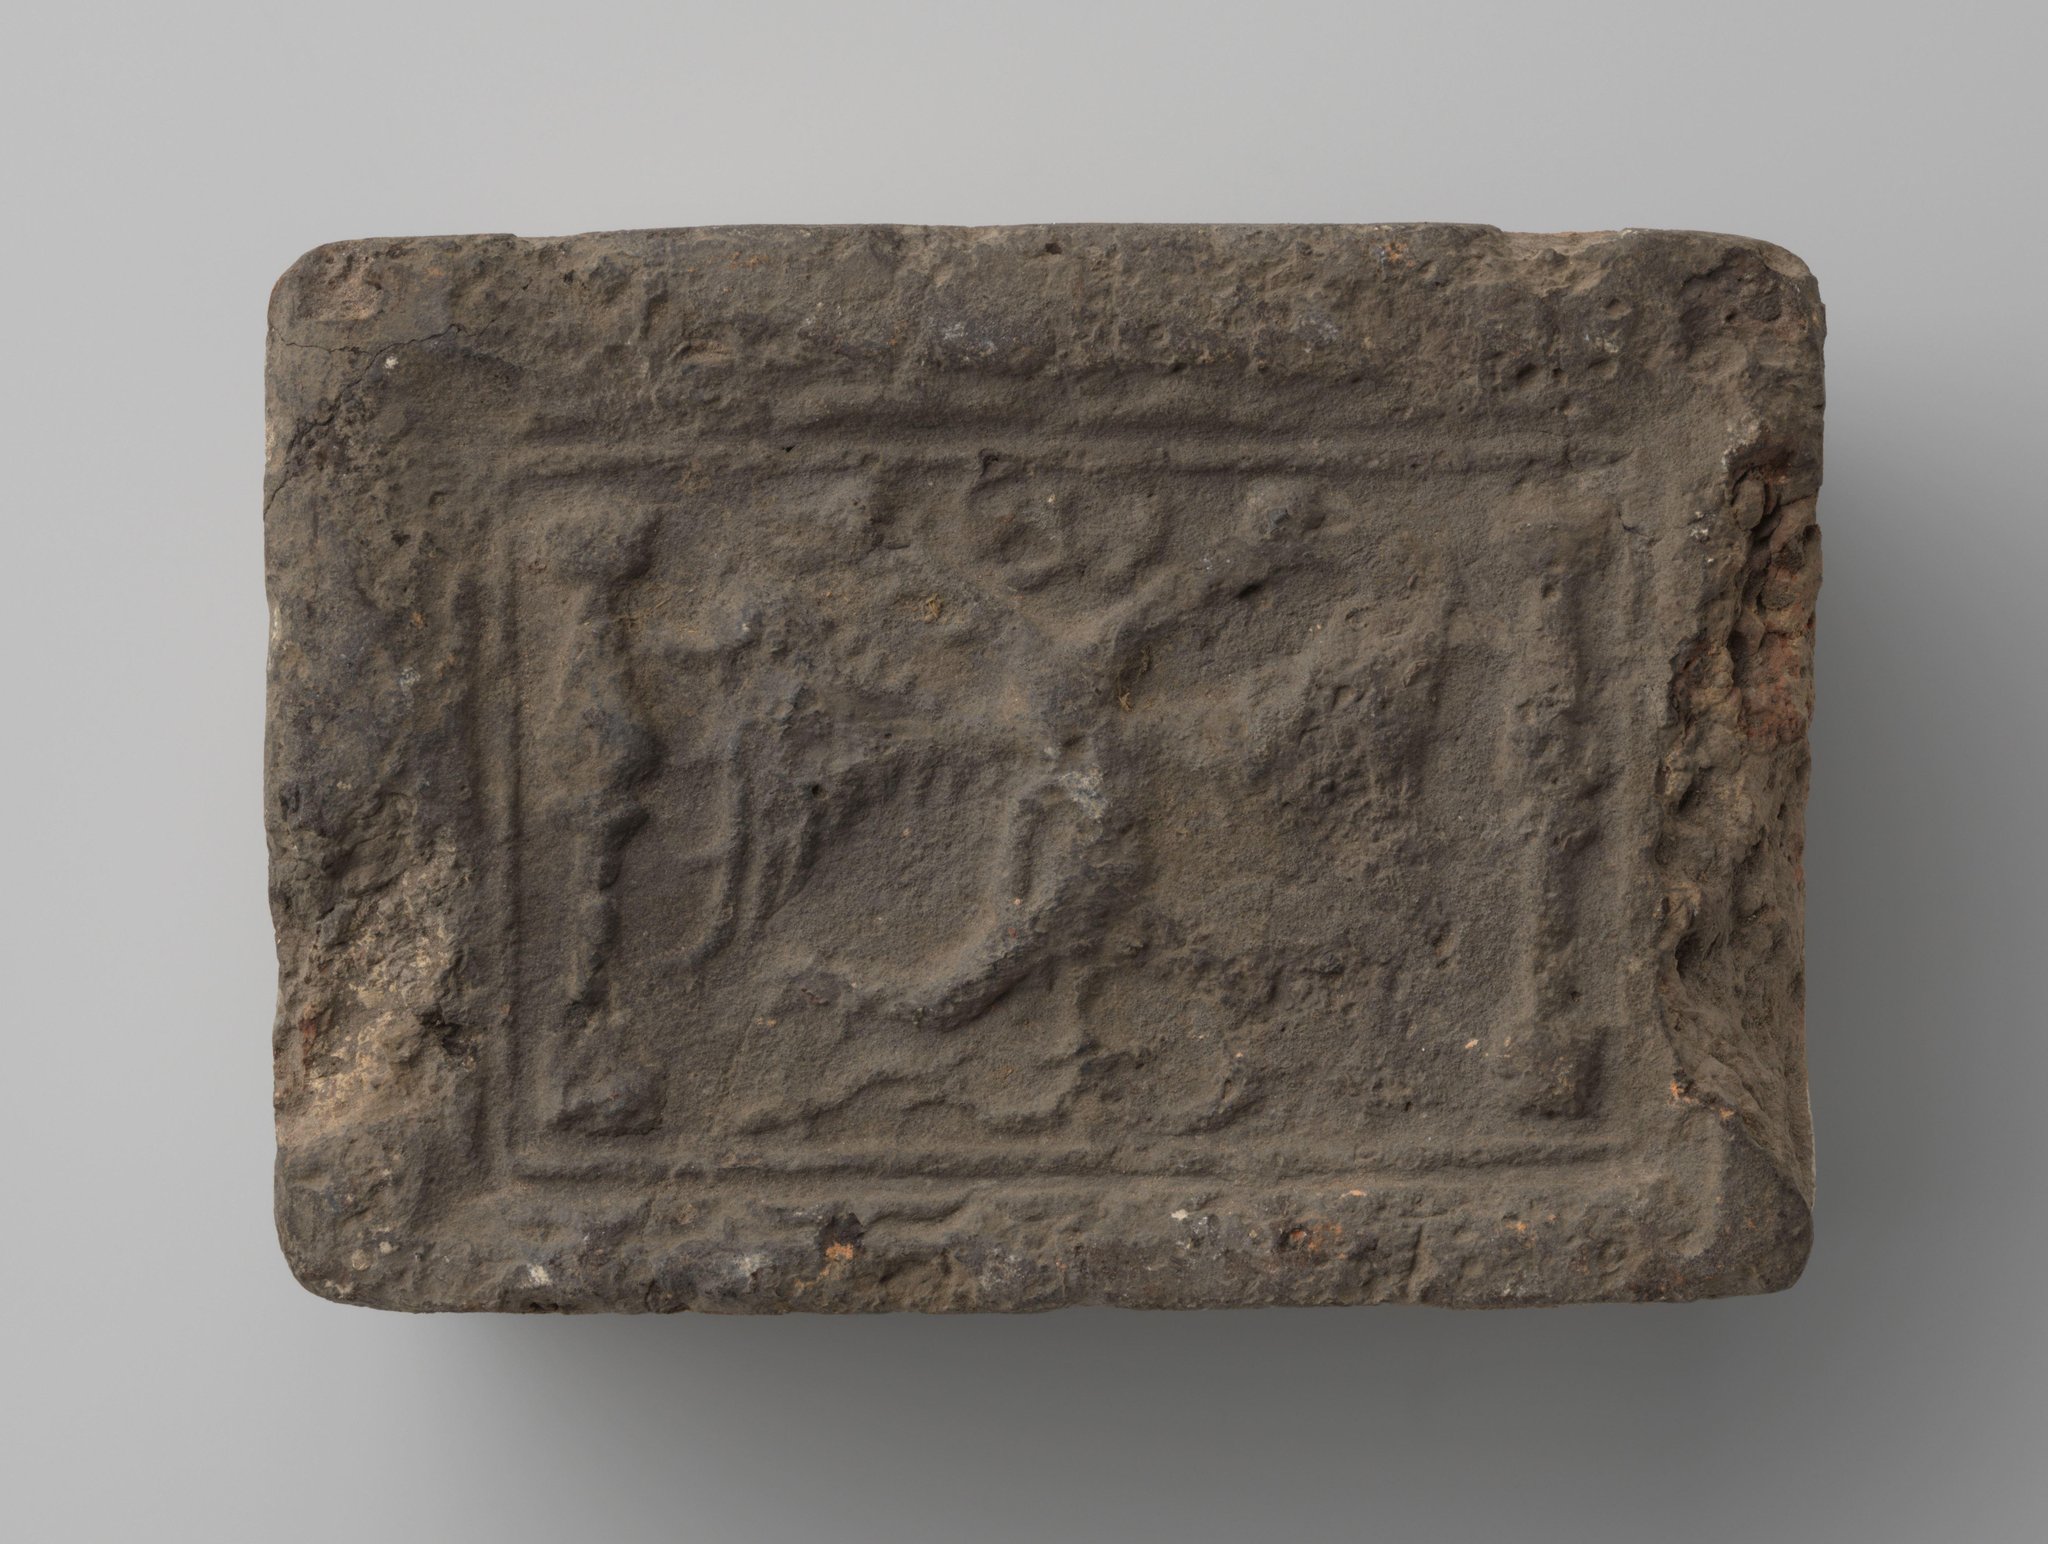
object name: hearthstone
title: Haardsteen met voorstelling van de tweekoppige adelaar tussen de zuilen van Hercules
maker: Anonymous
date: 1550-1600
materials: earthenware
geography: southern netherlands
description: Haardsteen met voorstelling van de tweekoppige adelaar tussen de zuilen van Hercules.